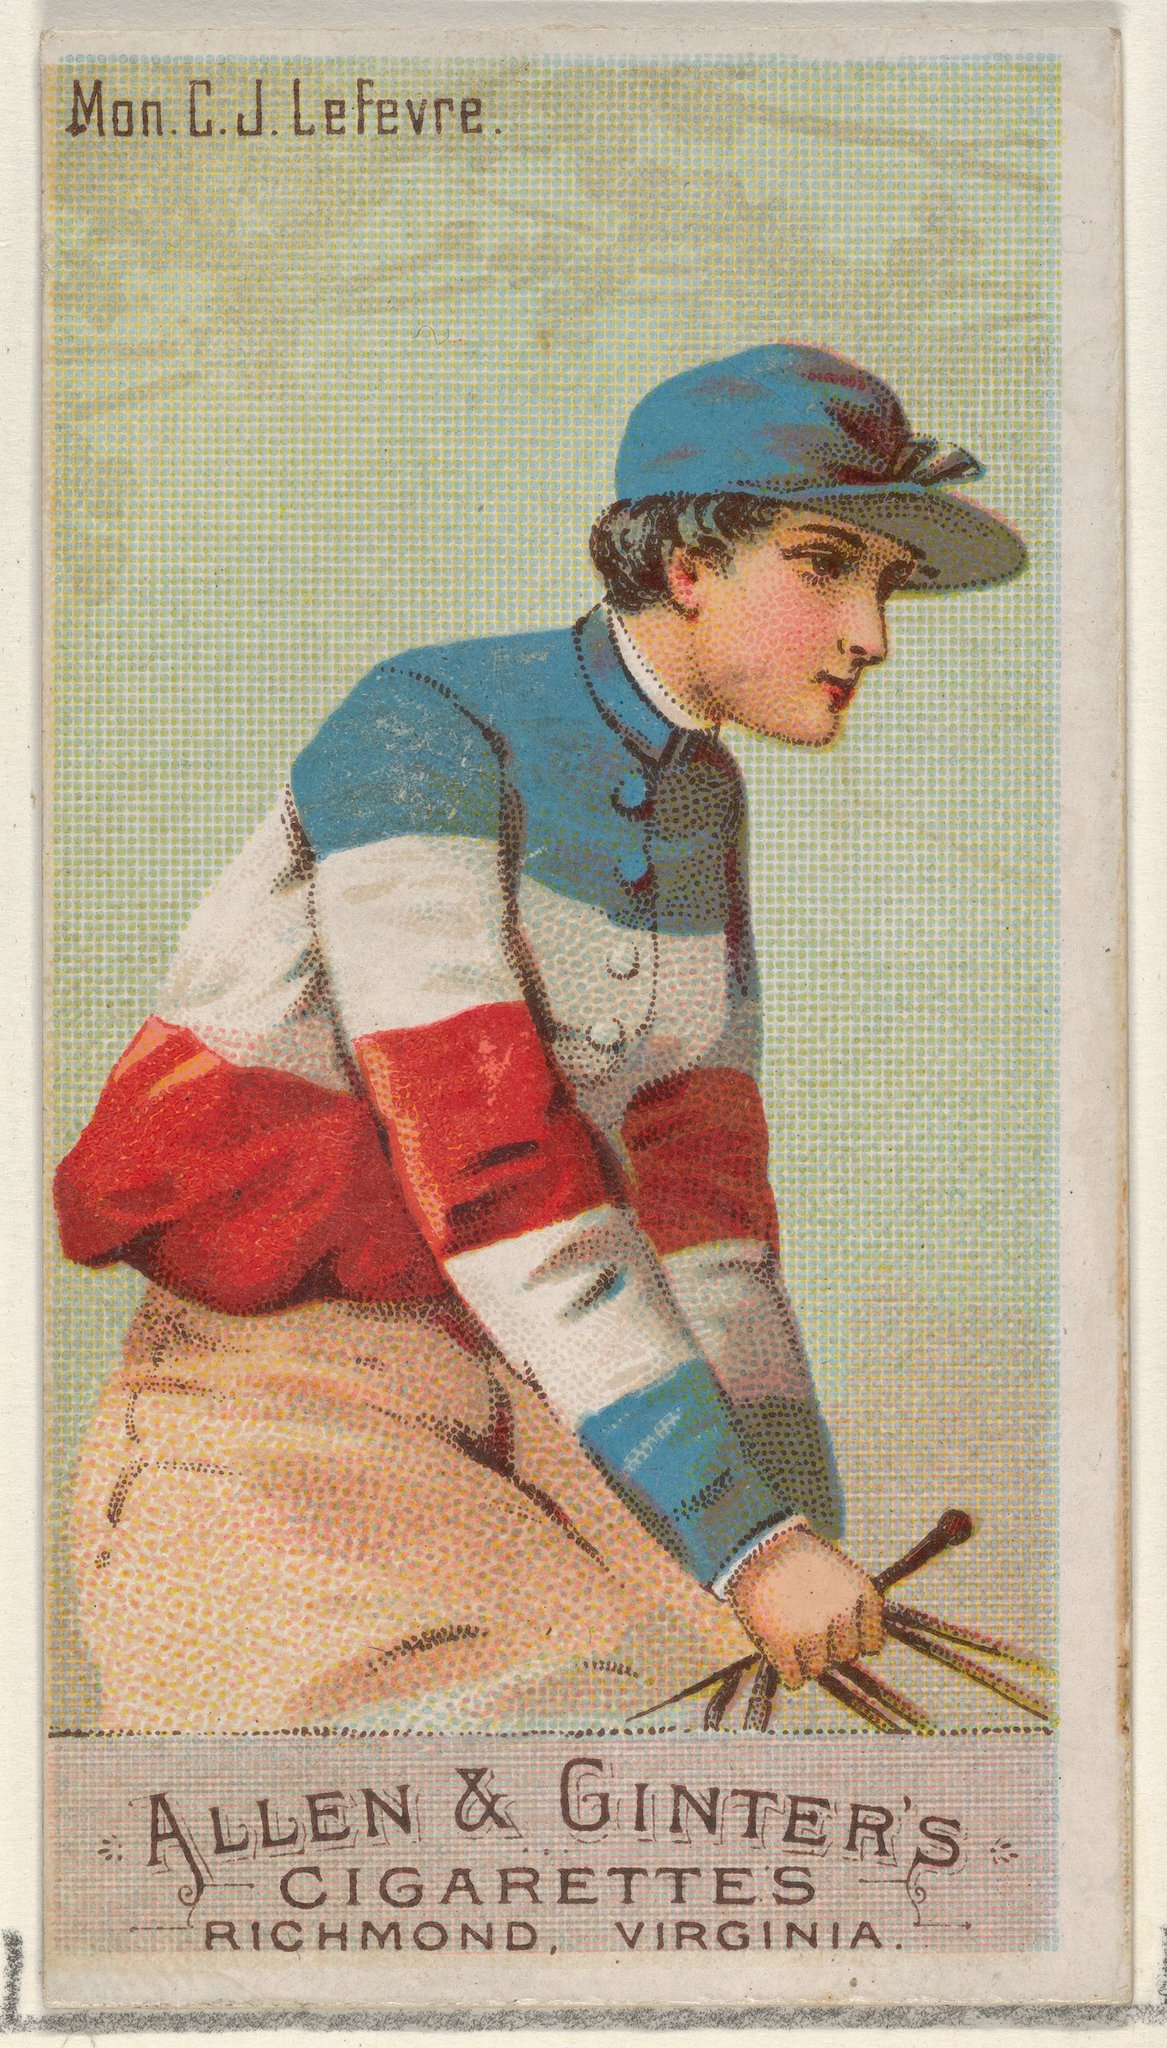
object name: print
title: Mon. C.J. Lefevre, from the Racing Colors of the World series (N22a) for Allen & Ginter Cigarettes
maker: allen & ginter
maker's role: publisher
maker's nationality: american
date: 1888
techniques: color lithograph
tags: women,jockeys